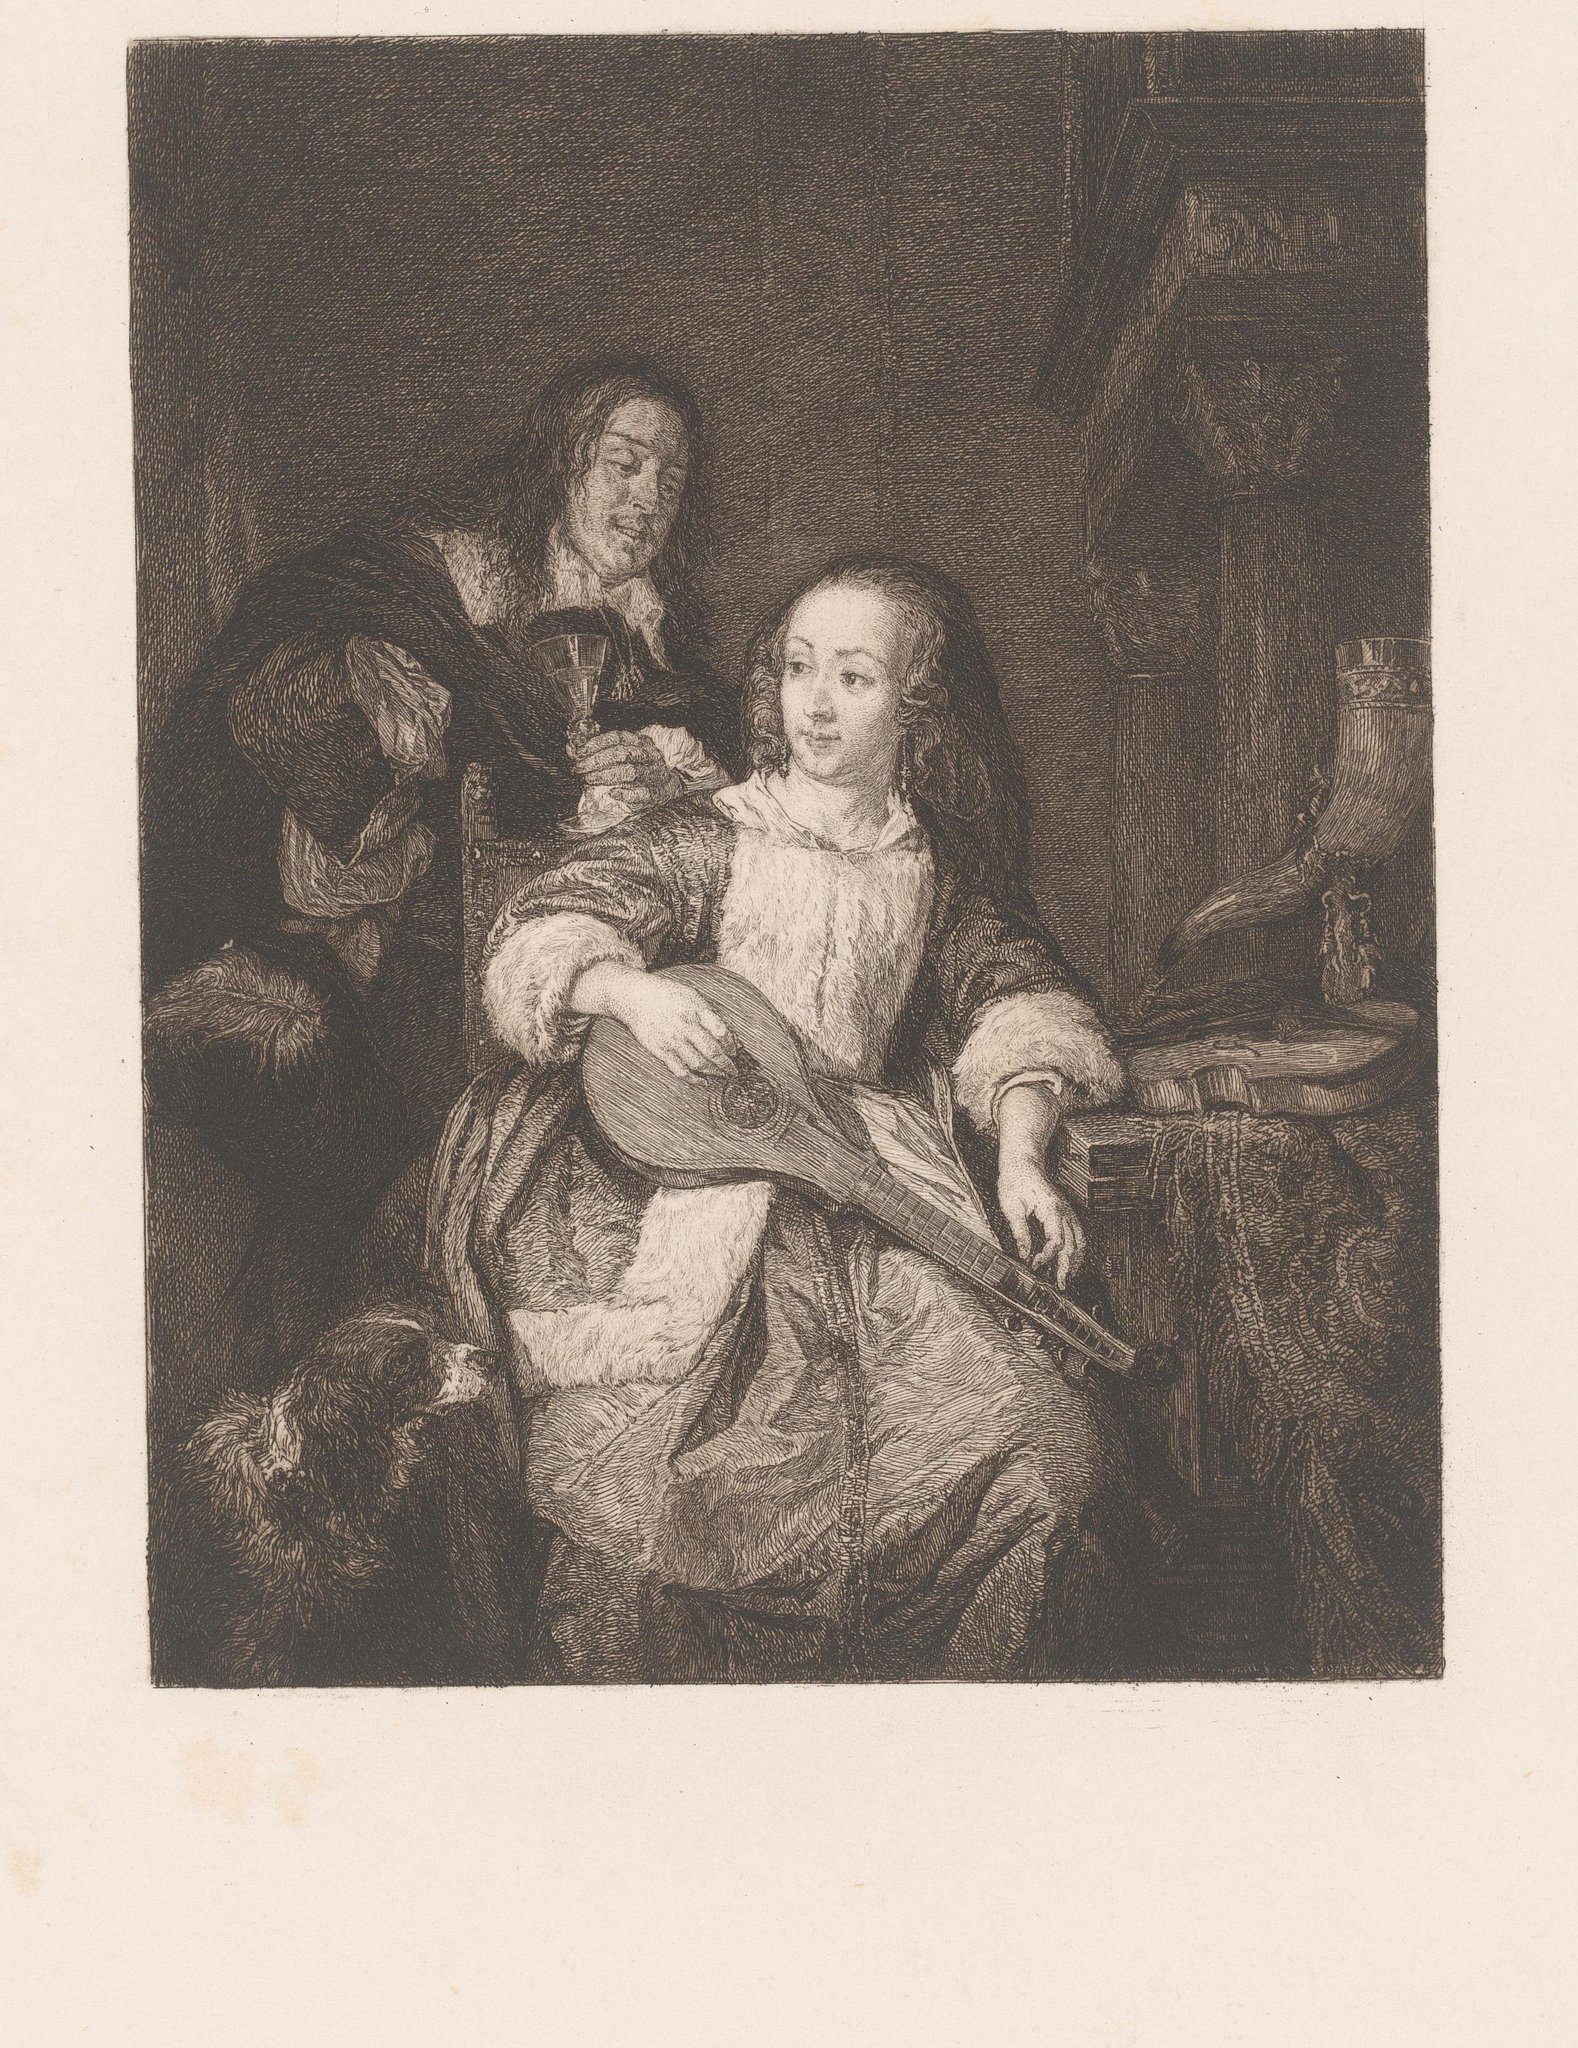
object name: print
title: Jonge vrouw die een cister stemt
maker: william unger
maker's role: draughtsman, painter, print maker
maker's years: 1837-1932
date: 1847-1889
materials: paper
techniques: etching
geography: germany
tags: violin, fiddle, tuning the lute, lute, and special forms of lute, e.g.: theorbo, drinking-horn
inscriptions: collector's mark: Lugt 2228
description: Prent naar het schilderij door Gabriël Metsu in de Gemäldegalerie Alte Meister te Kassel (inv.nr. GK 301).